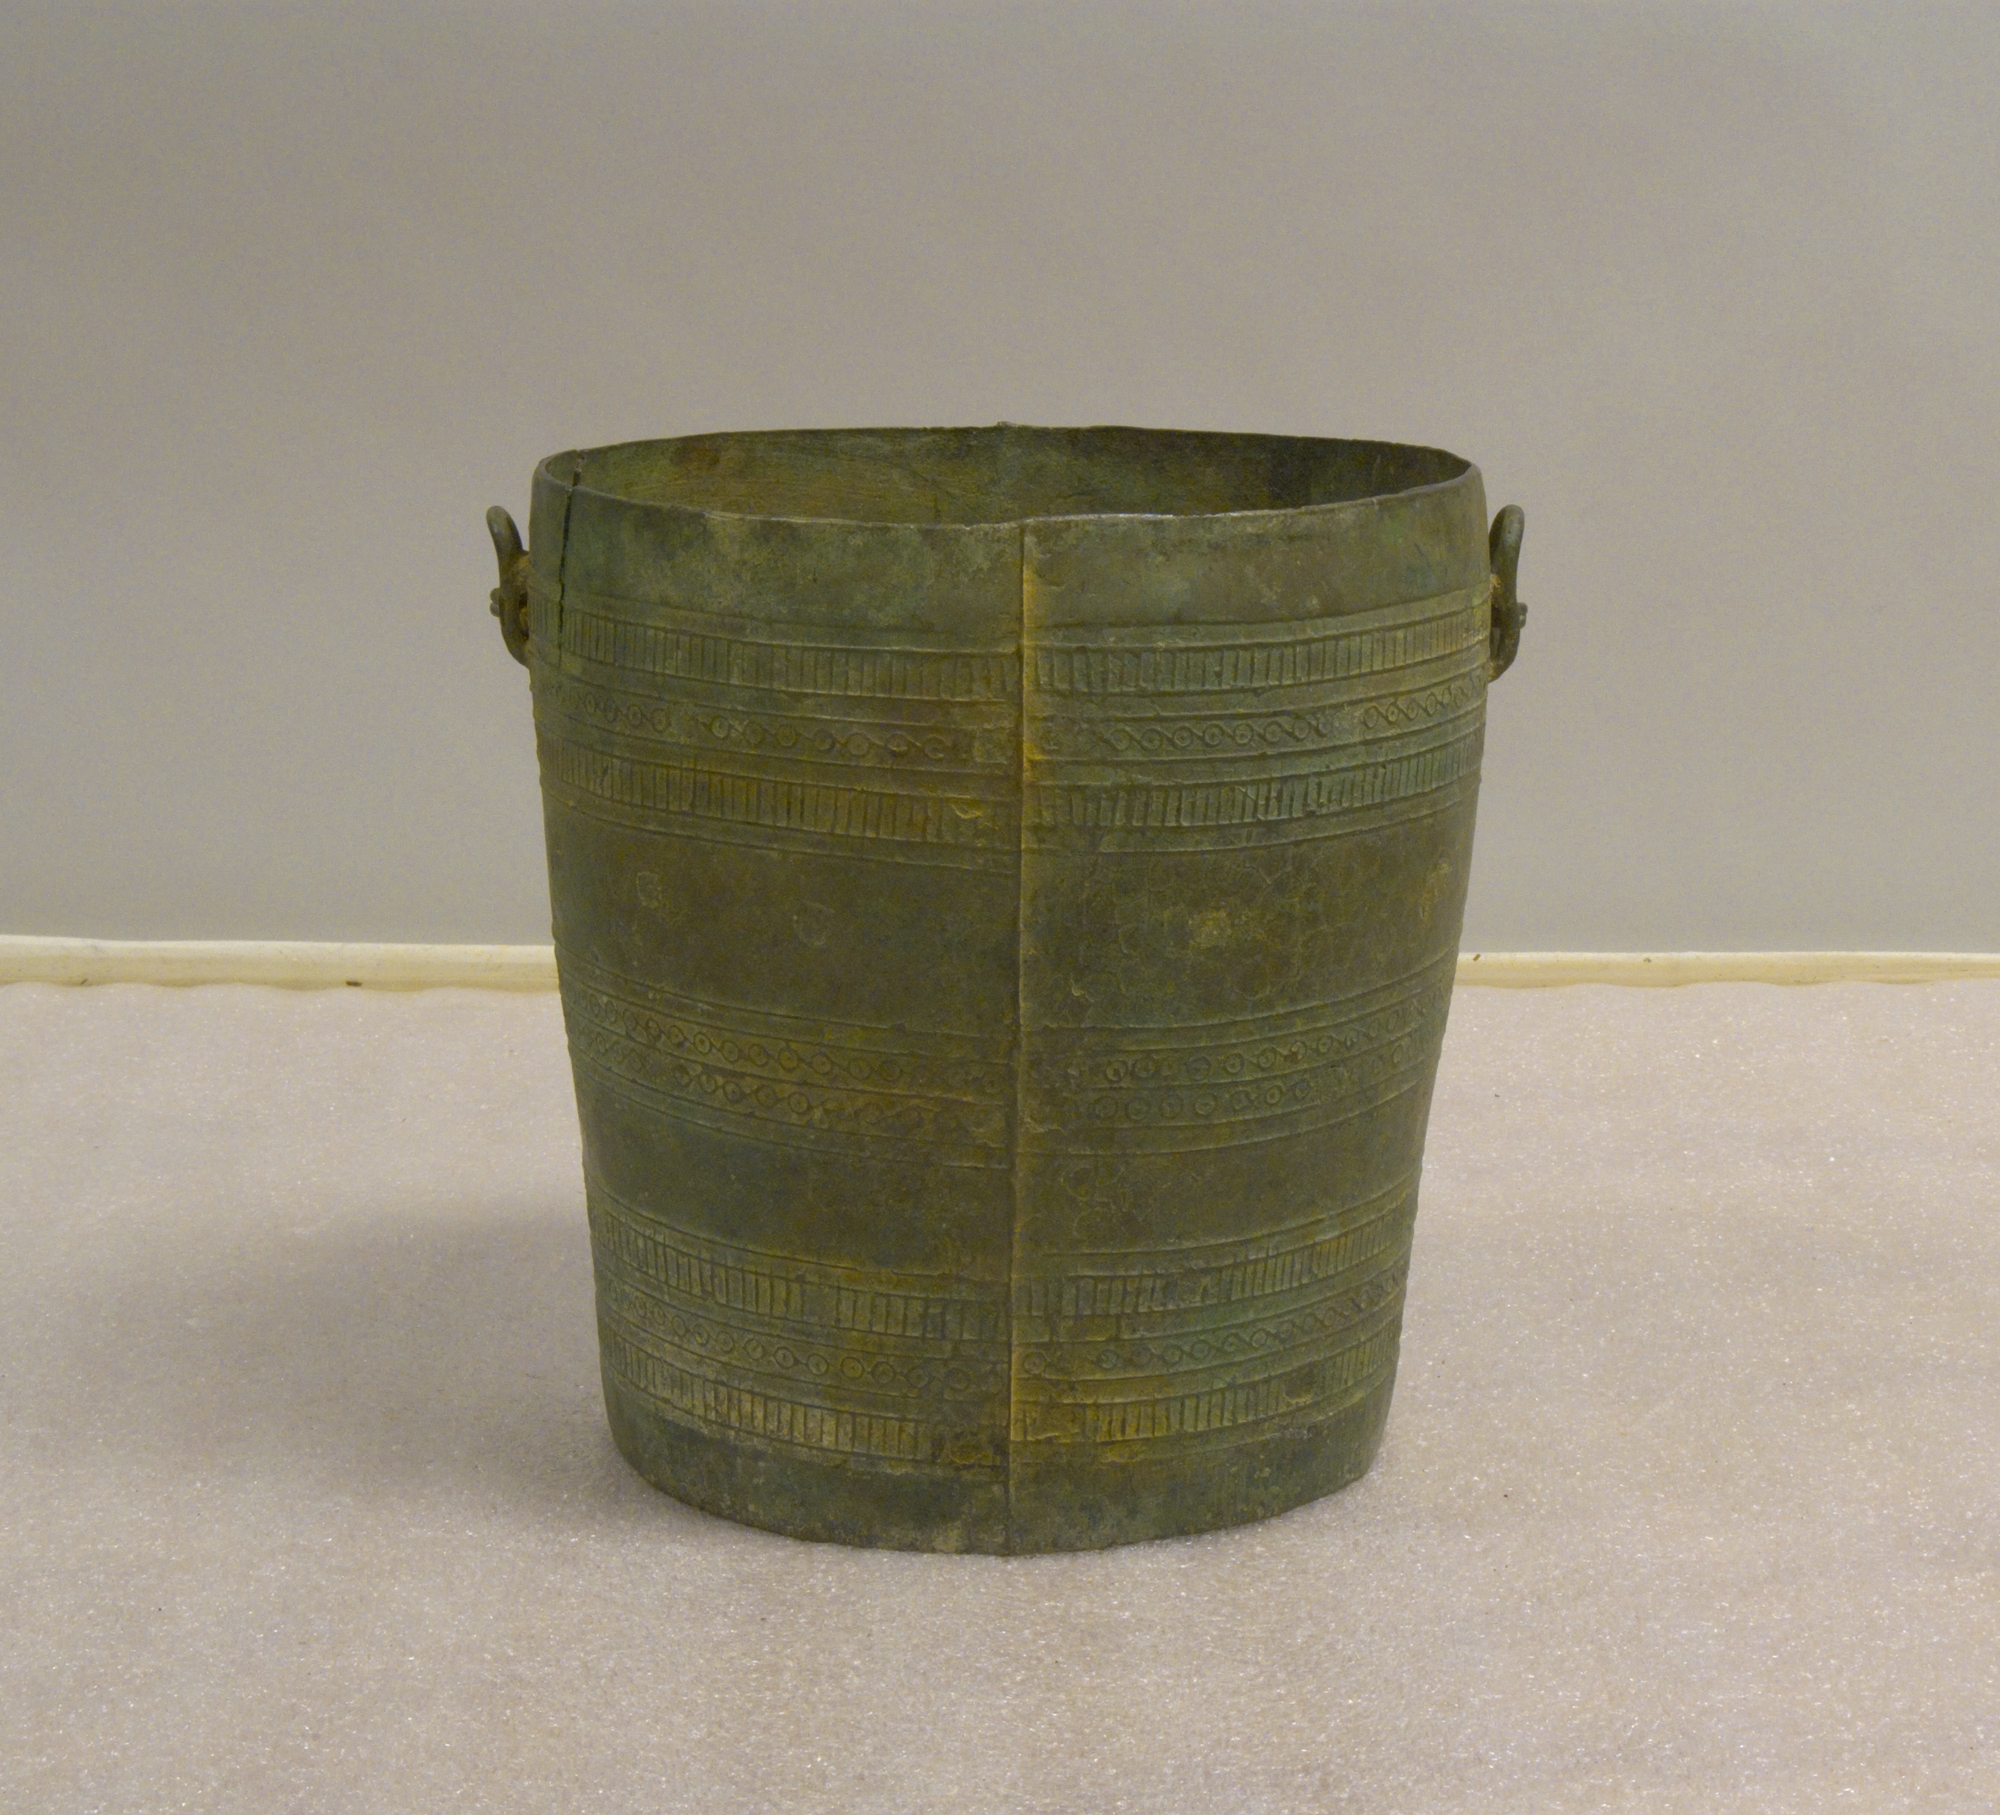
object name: situla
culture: vietnamese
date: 500 BCE-200 CE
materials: bronze